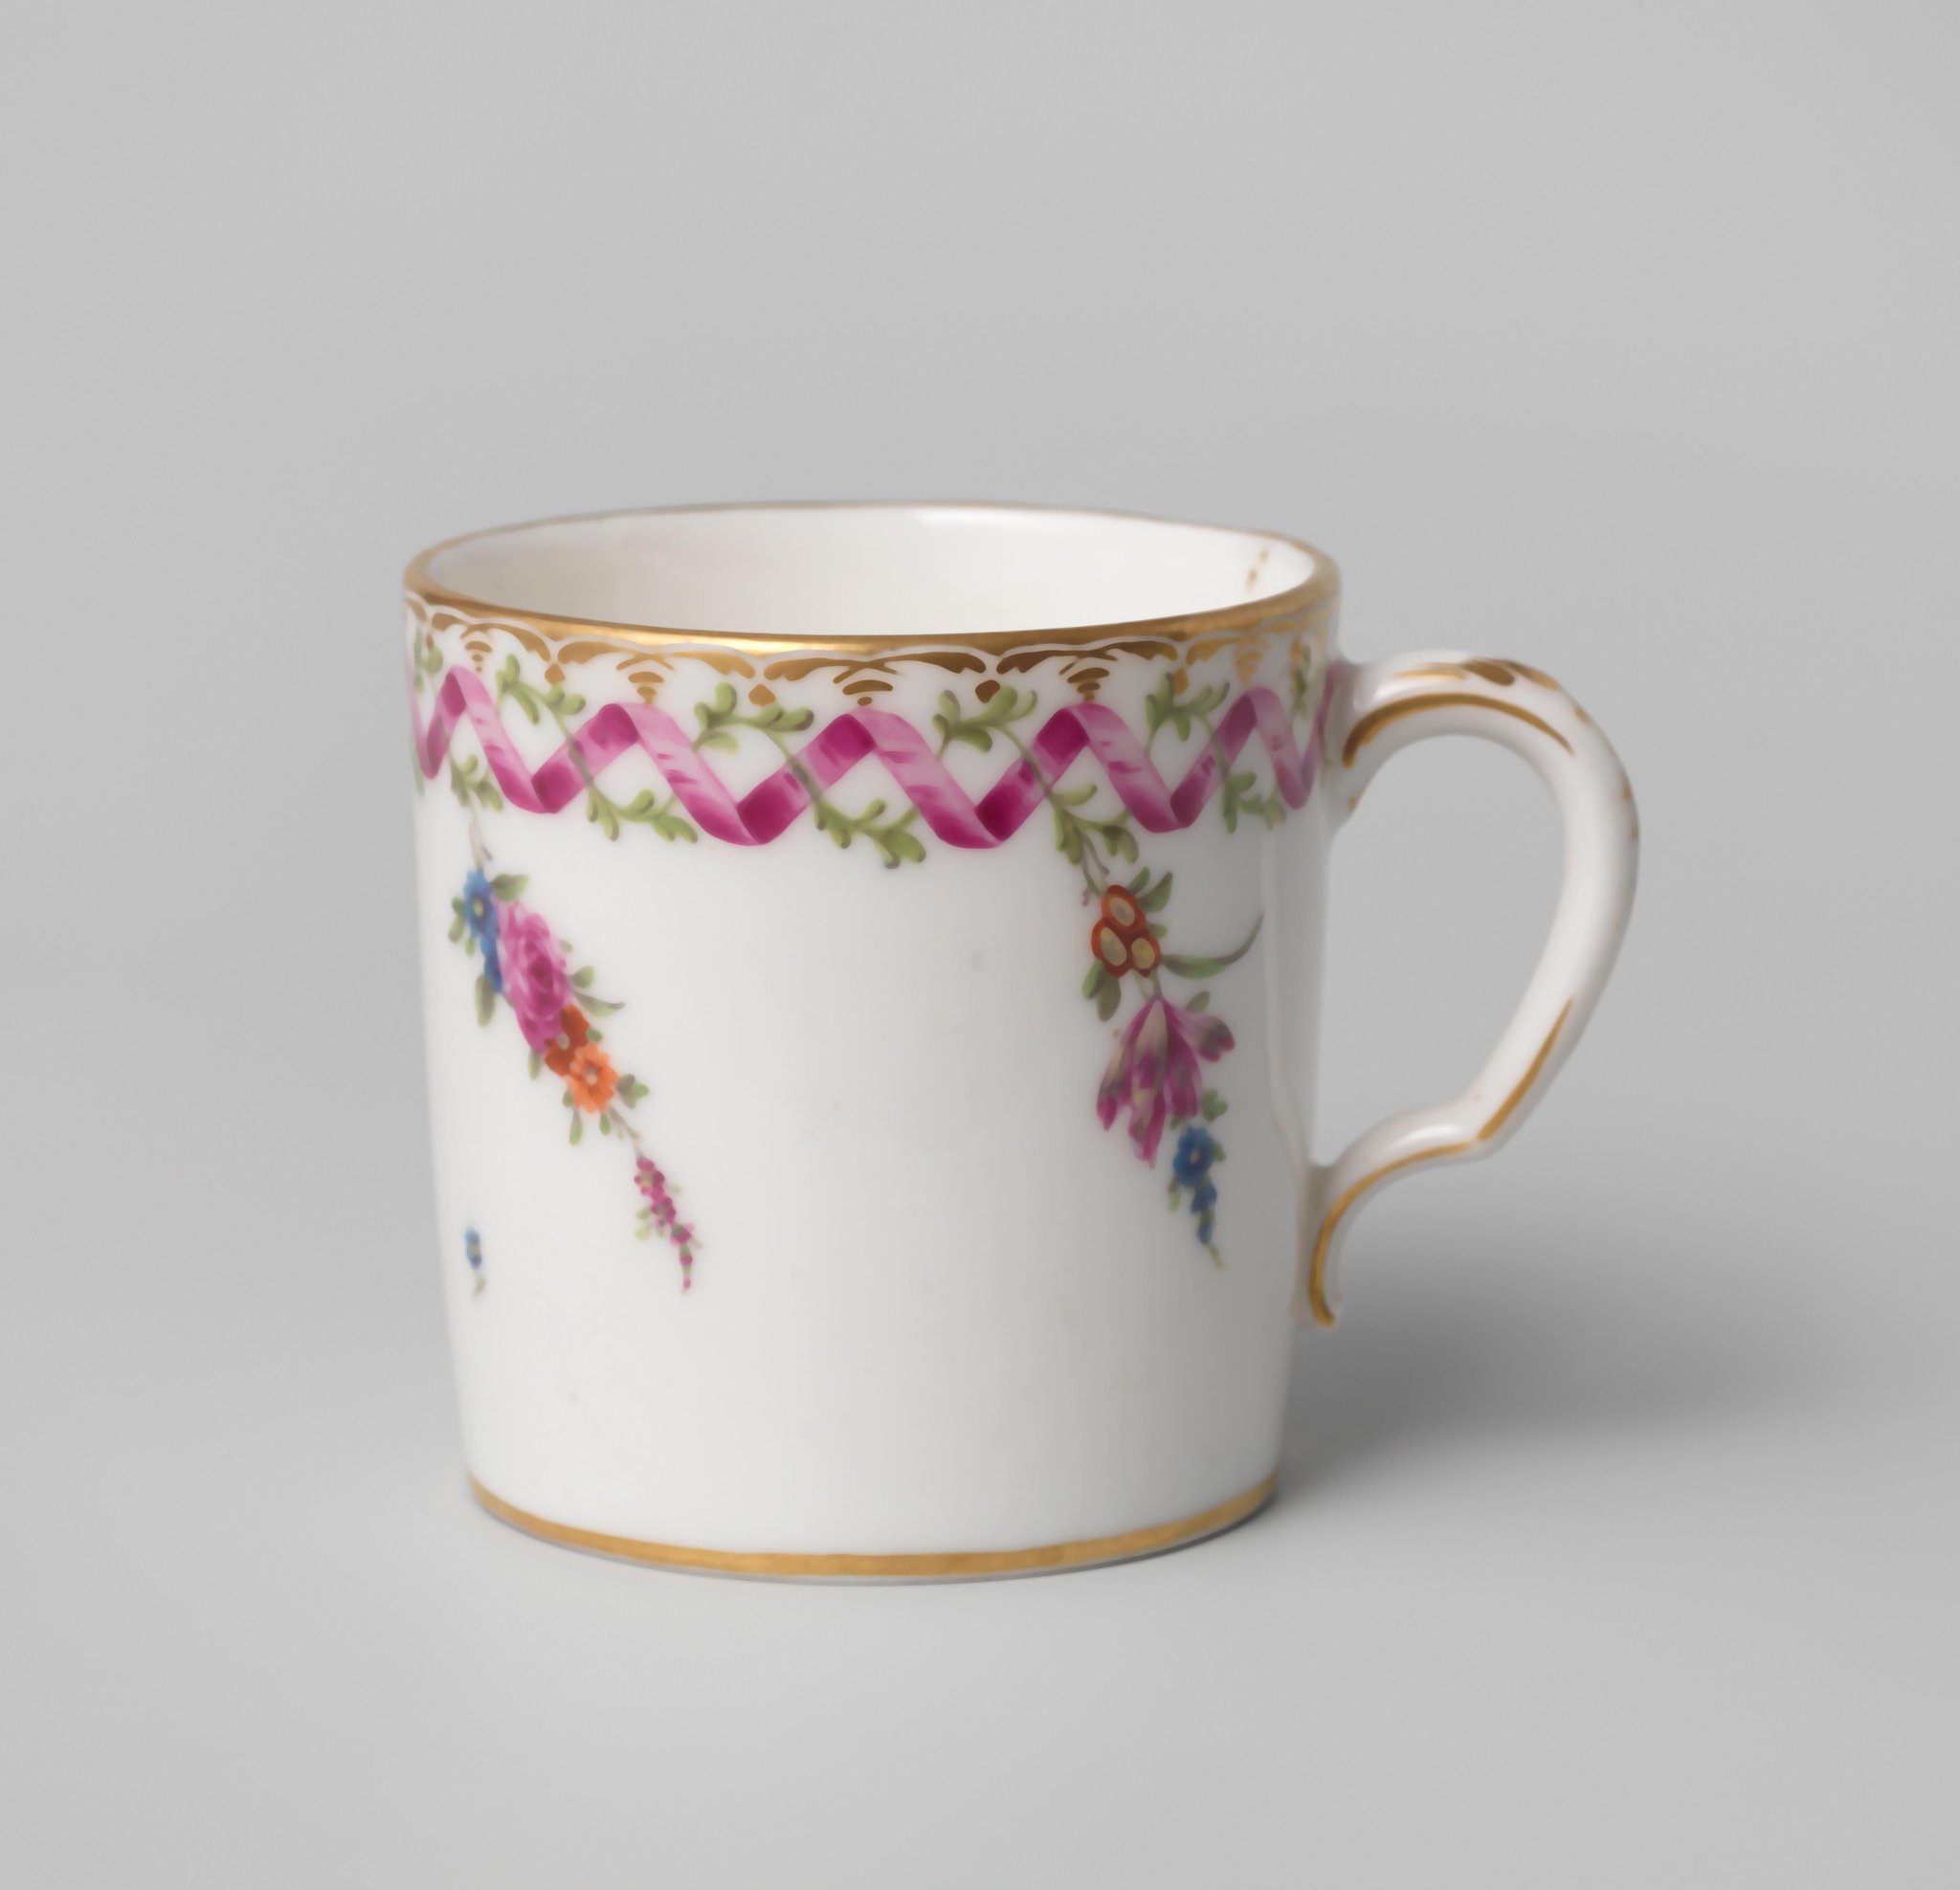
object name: cup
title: Kop, beschilderd met een zigzaglint, waaromheen een tak met bladeren slingert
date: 1778-1782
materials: porcelain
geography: loosdrecht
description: Coffee cup and saucer. Porcelain. Loosdrecht, c. 1778 - 1782. Factory of Joannes de Mol.